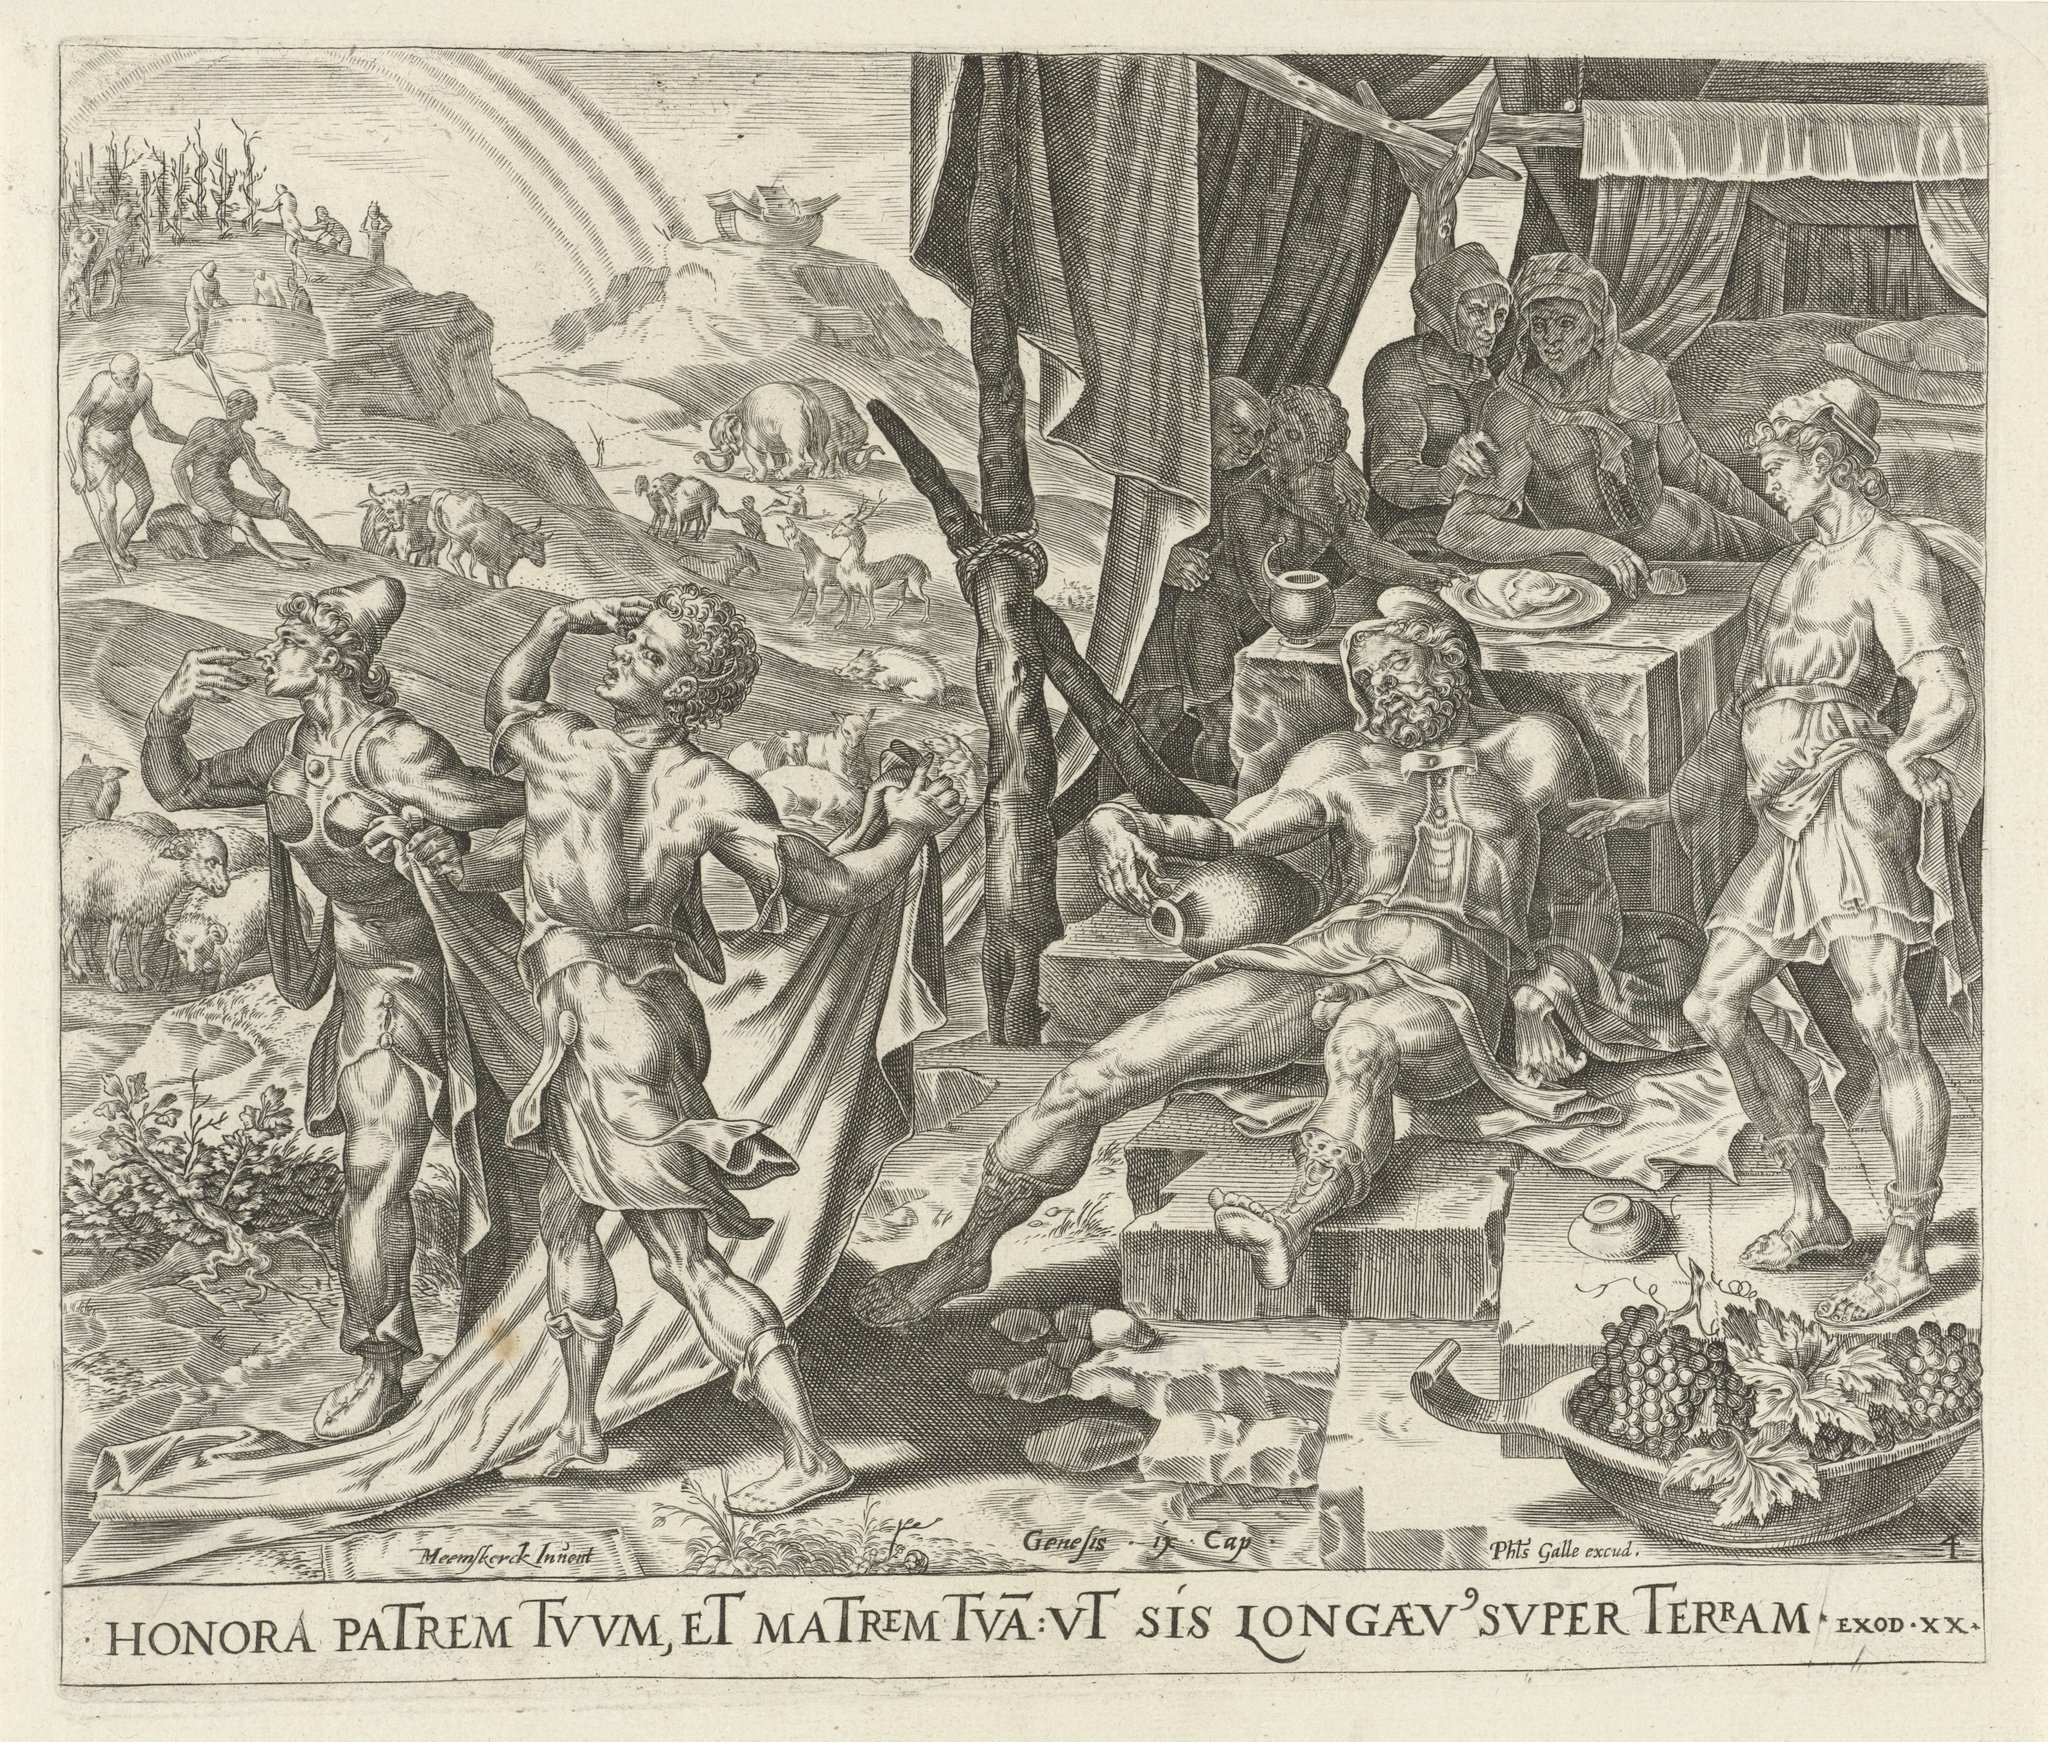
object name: print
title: Dronkenschap van Noach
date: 1570-1612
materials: paper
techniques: engraving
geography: antwerp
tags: shem and japheth cover their father noah; ham usually stands nearby deriding him, 'honour your father and your mother' ~ separate representation of the fifth of the ten commandments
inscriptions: collector's mark: Lugt 2228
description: De dronken Noach ligt voor zijn tent half naakt te slapen en wordt uitgelachen door Cham. Sem en Jafet lopen achteruit met een mantel om hun vader daarmee te bedekken. Prent maakt deel uit van een serie over de tien geboden en geeft een overtreding van het vierde gebod weer: Eer uw vader en uw moeder. Onderaan in de marge een verwijzing naar de Bijbeltekst in het Latijn.